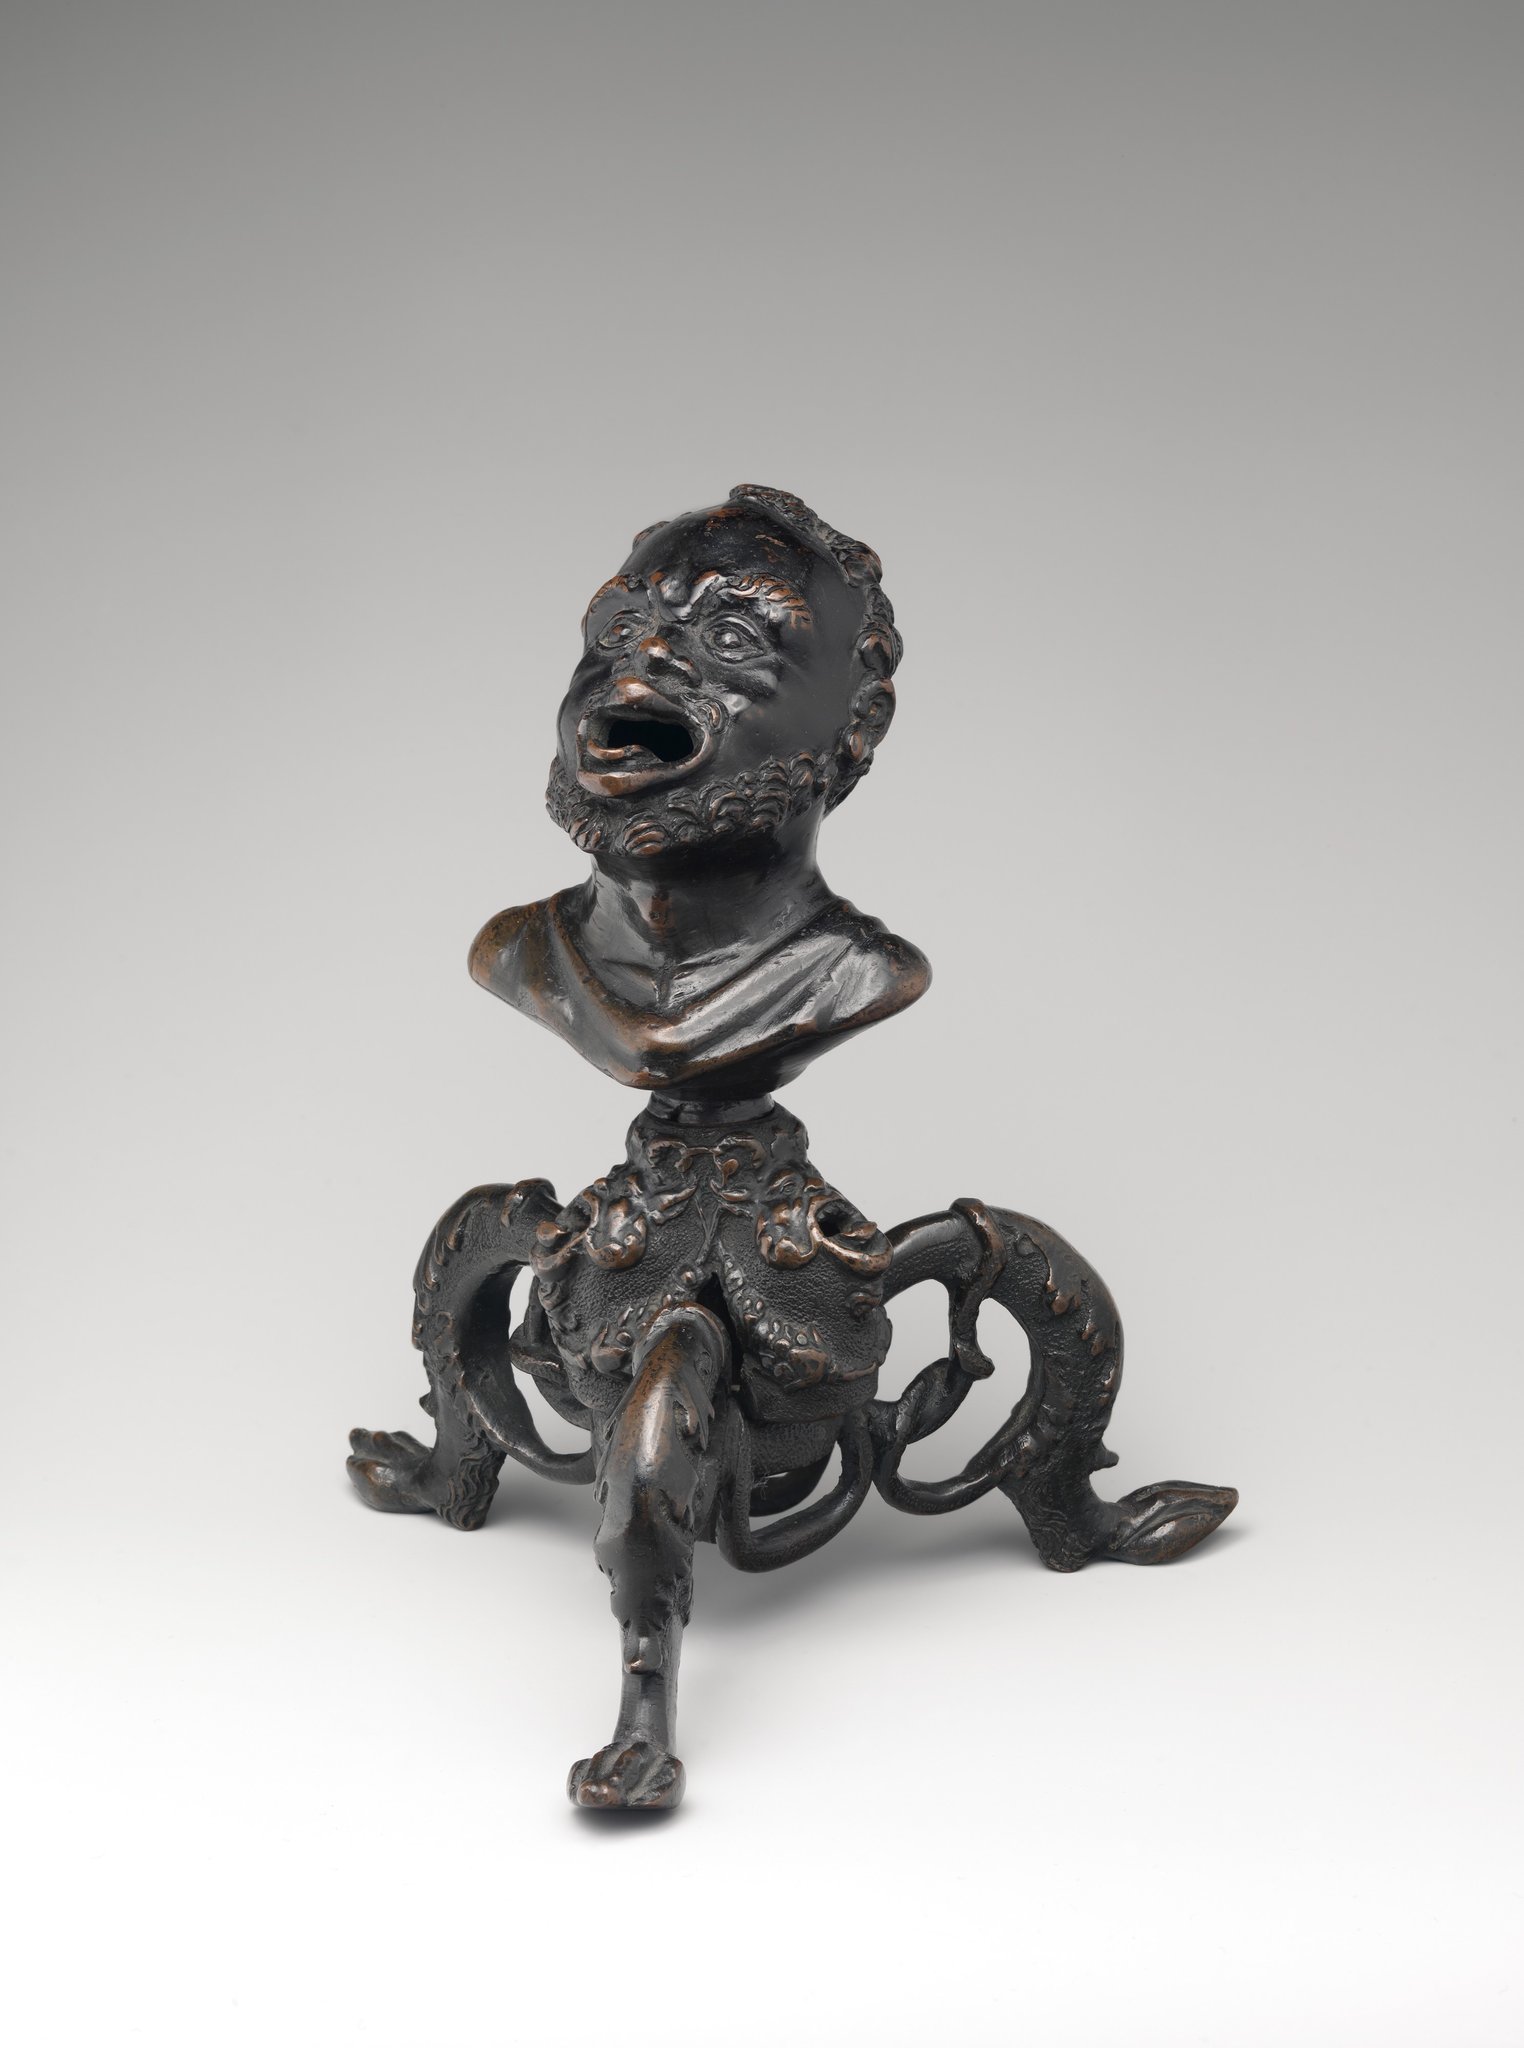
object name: oil lamp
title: Oil lamp based on the form of an African’s head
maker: andrea briosco, called riccio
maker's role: artist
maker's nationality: italian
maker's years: 1470-1532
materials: bronze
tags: heads,men